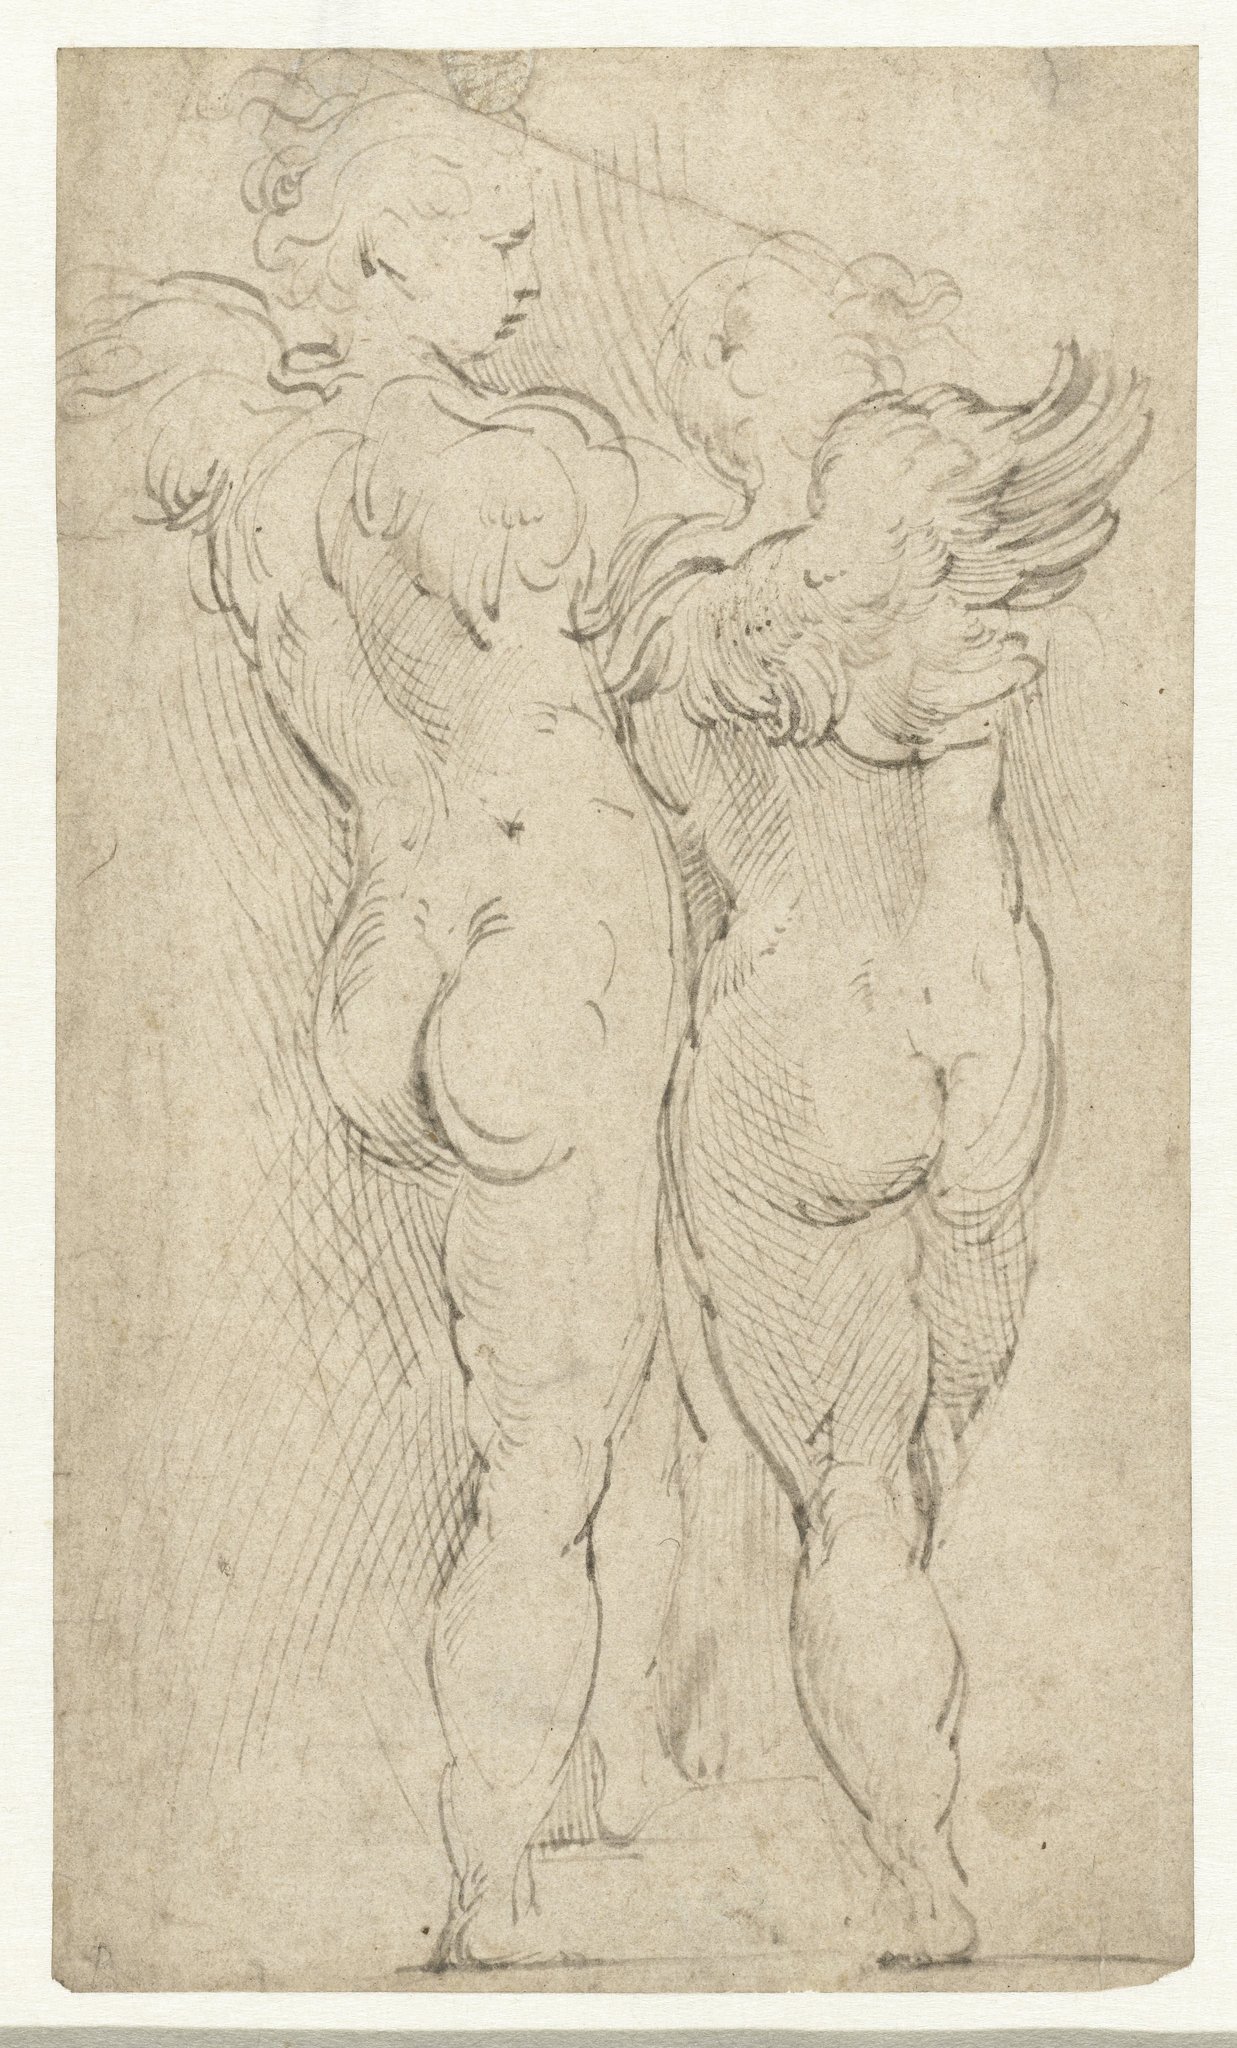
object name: drawing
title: Twee gevleugelde putti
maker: parmigianino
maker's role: draughtsman, painter, print maker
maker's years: 1503-1540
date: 1527-1529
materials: ink, paper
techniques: pen